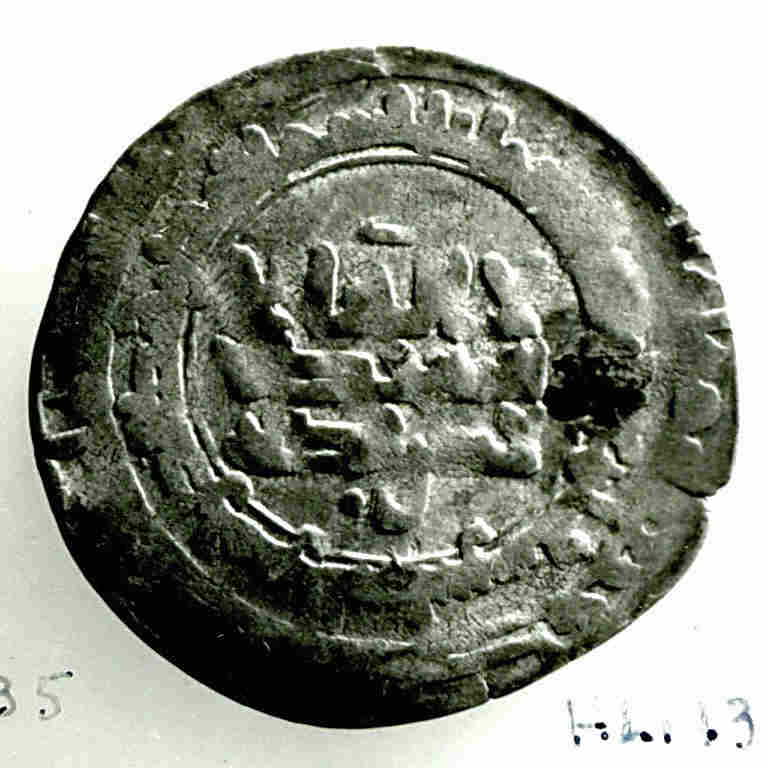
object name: coin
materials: silver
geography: al-shash